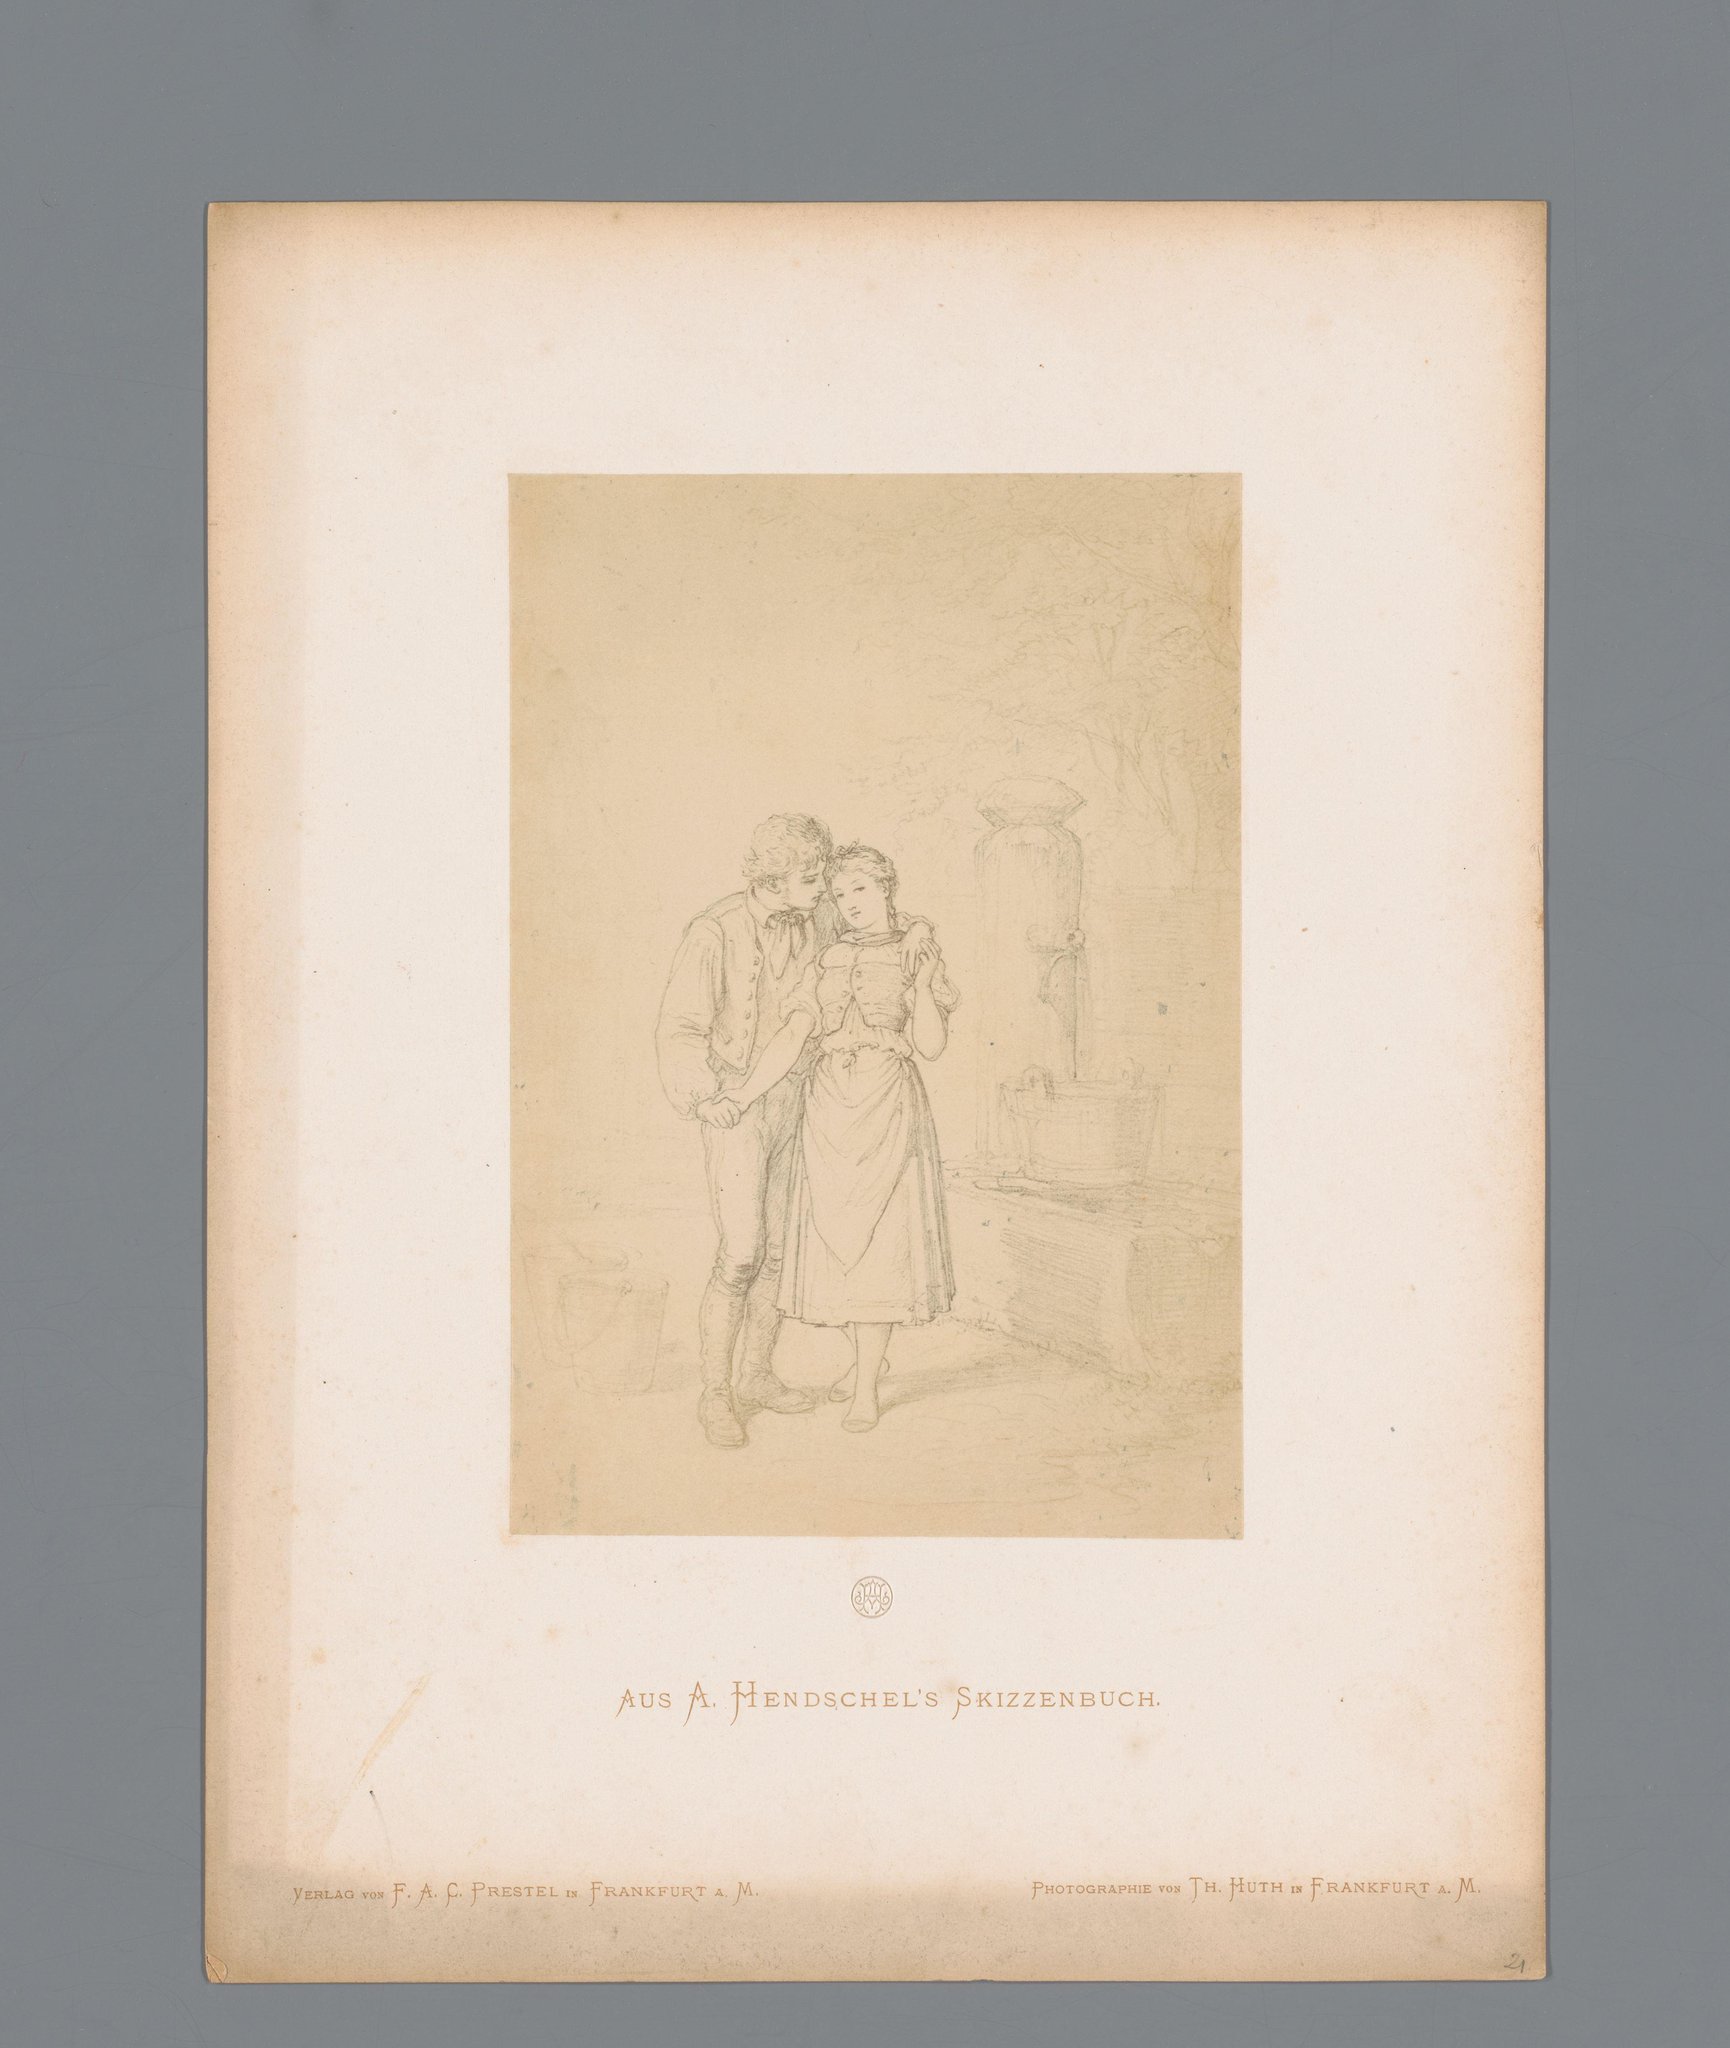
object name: reproduction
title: Fotoreproductie van een schets van een liefdespaar bij een waterput door Albert Hendschel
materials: photographic support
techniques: albumen print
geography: frankfurt am main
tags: well, couple of lovers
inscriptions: monogram: ‘AH’, number: ‘21’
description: Deze foto maakt deel uit van een omslag met 50 foto's op 48 bladen, een lijst van afbeeldingen en een titelblad.